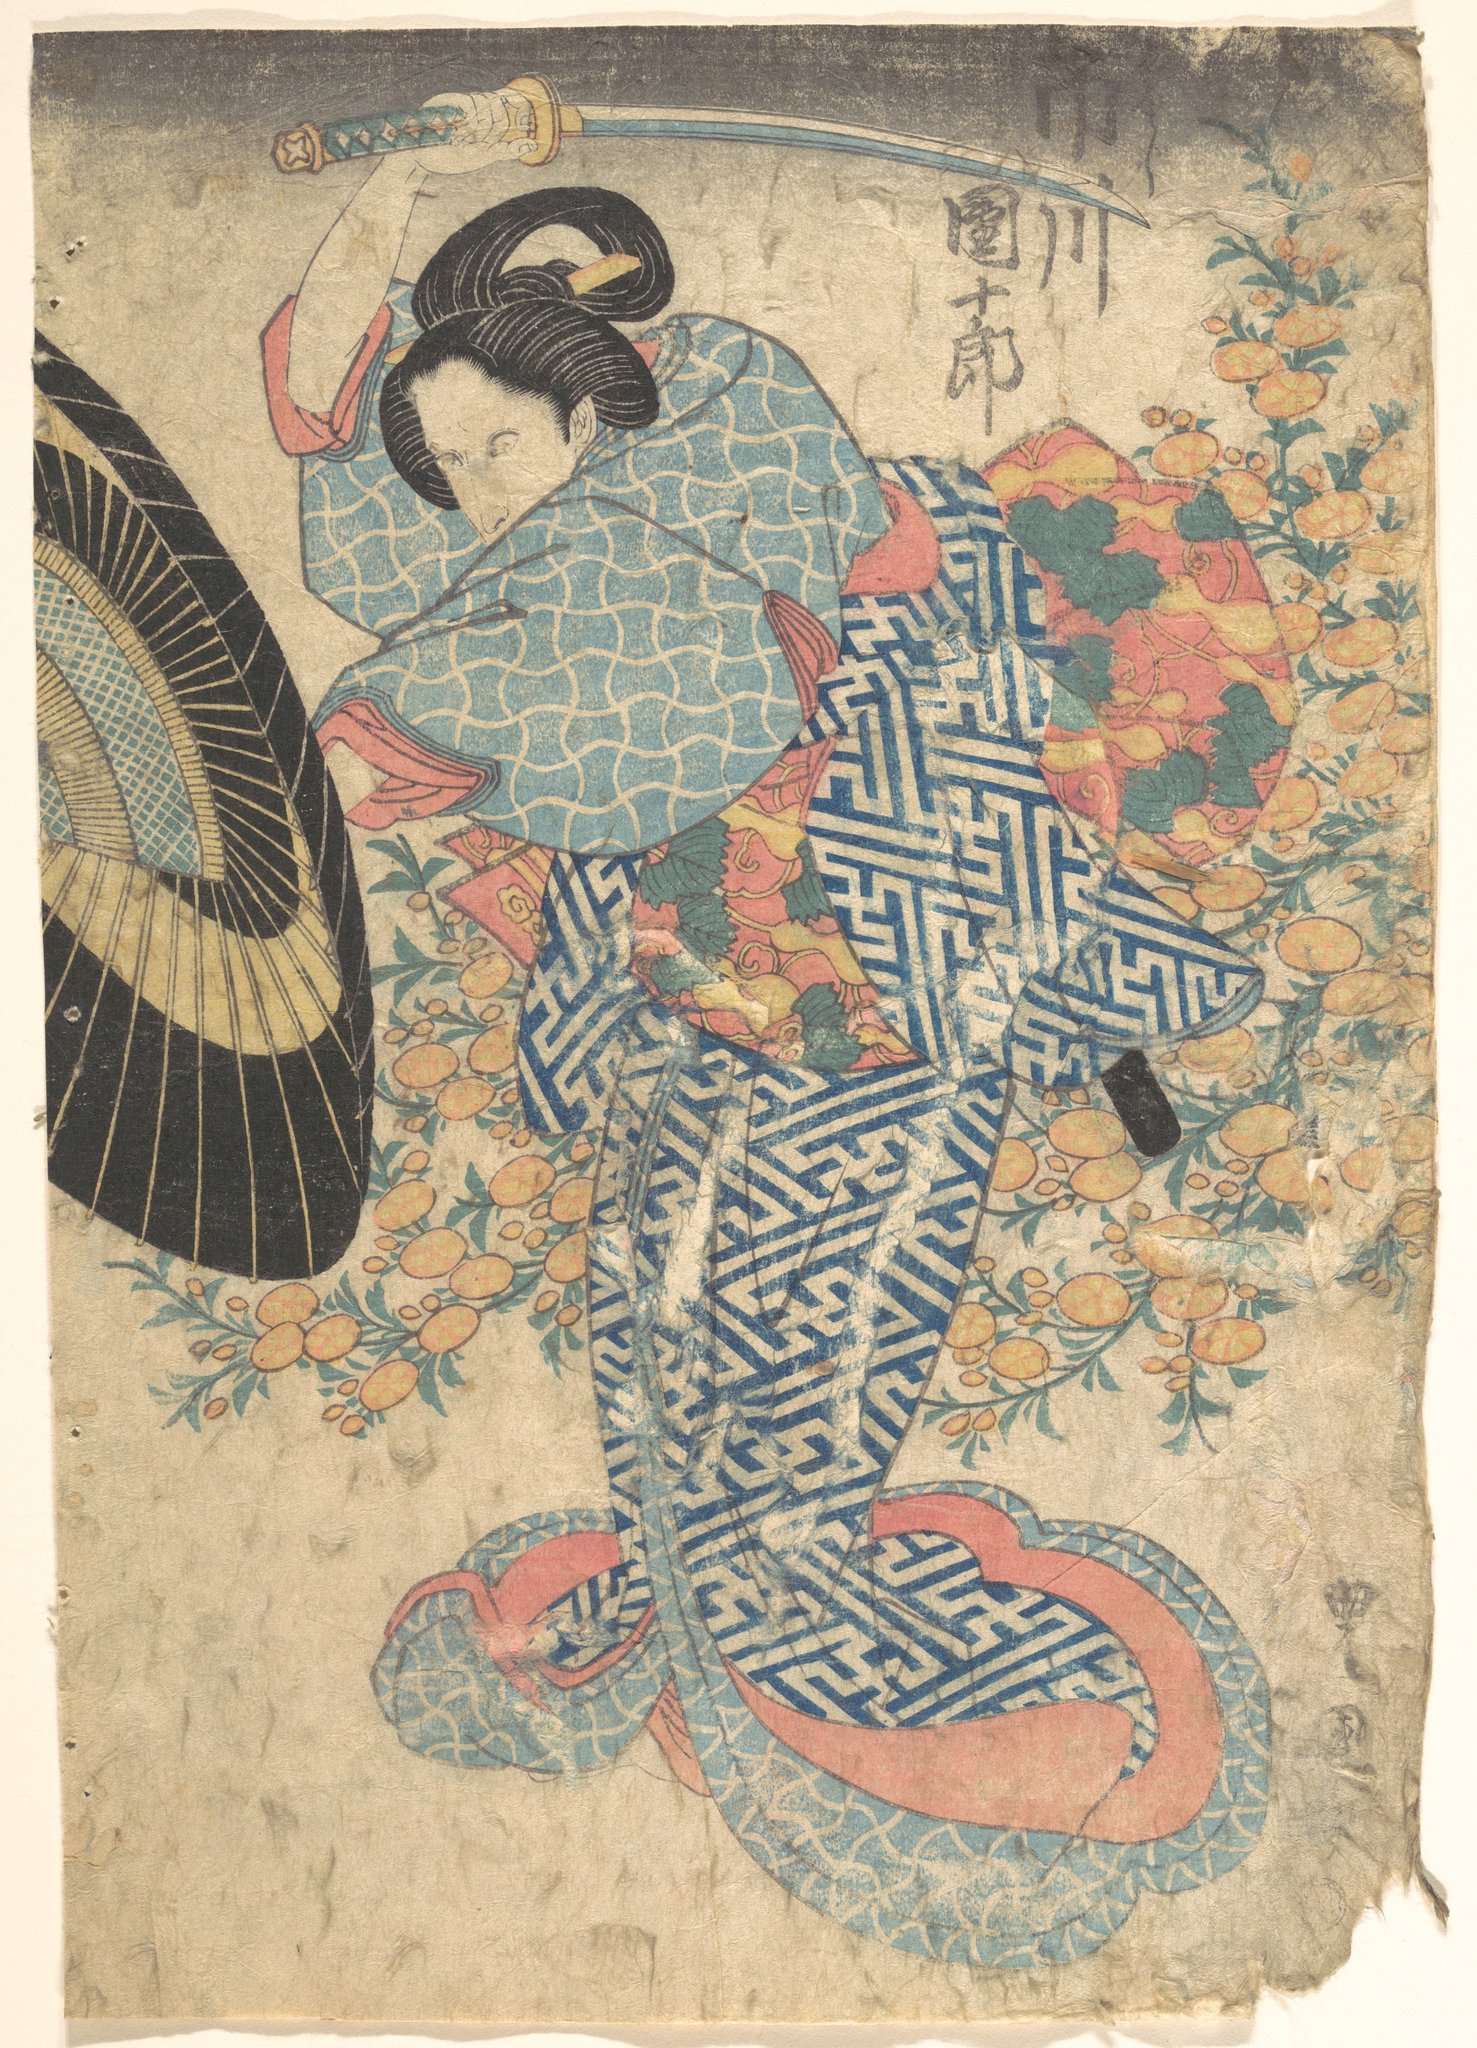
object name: print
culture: japanese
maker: utagawa kunisada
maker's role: artist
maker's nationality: japanese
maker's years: 1786-1864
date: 1801-1900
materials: ink, paper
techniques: woodblock print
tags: swords,men